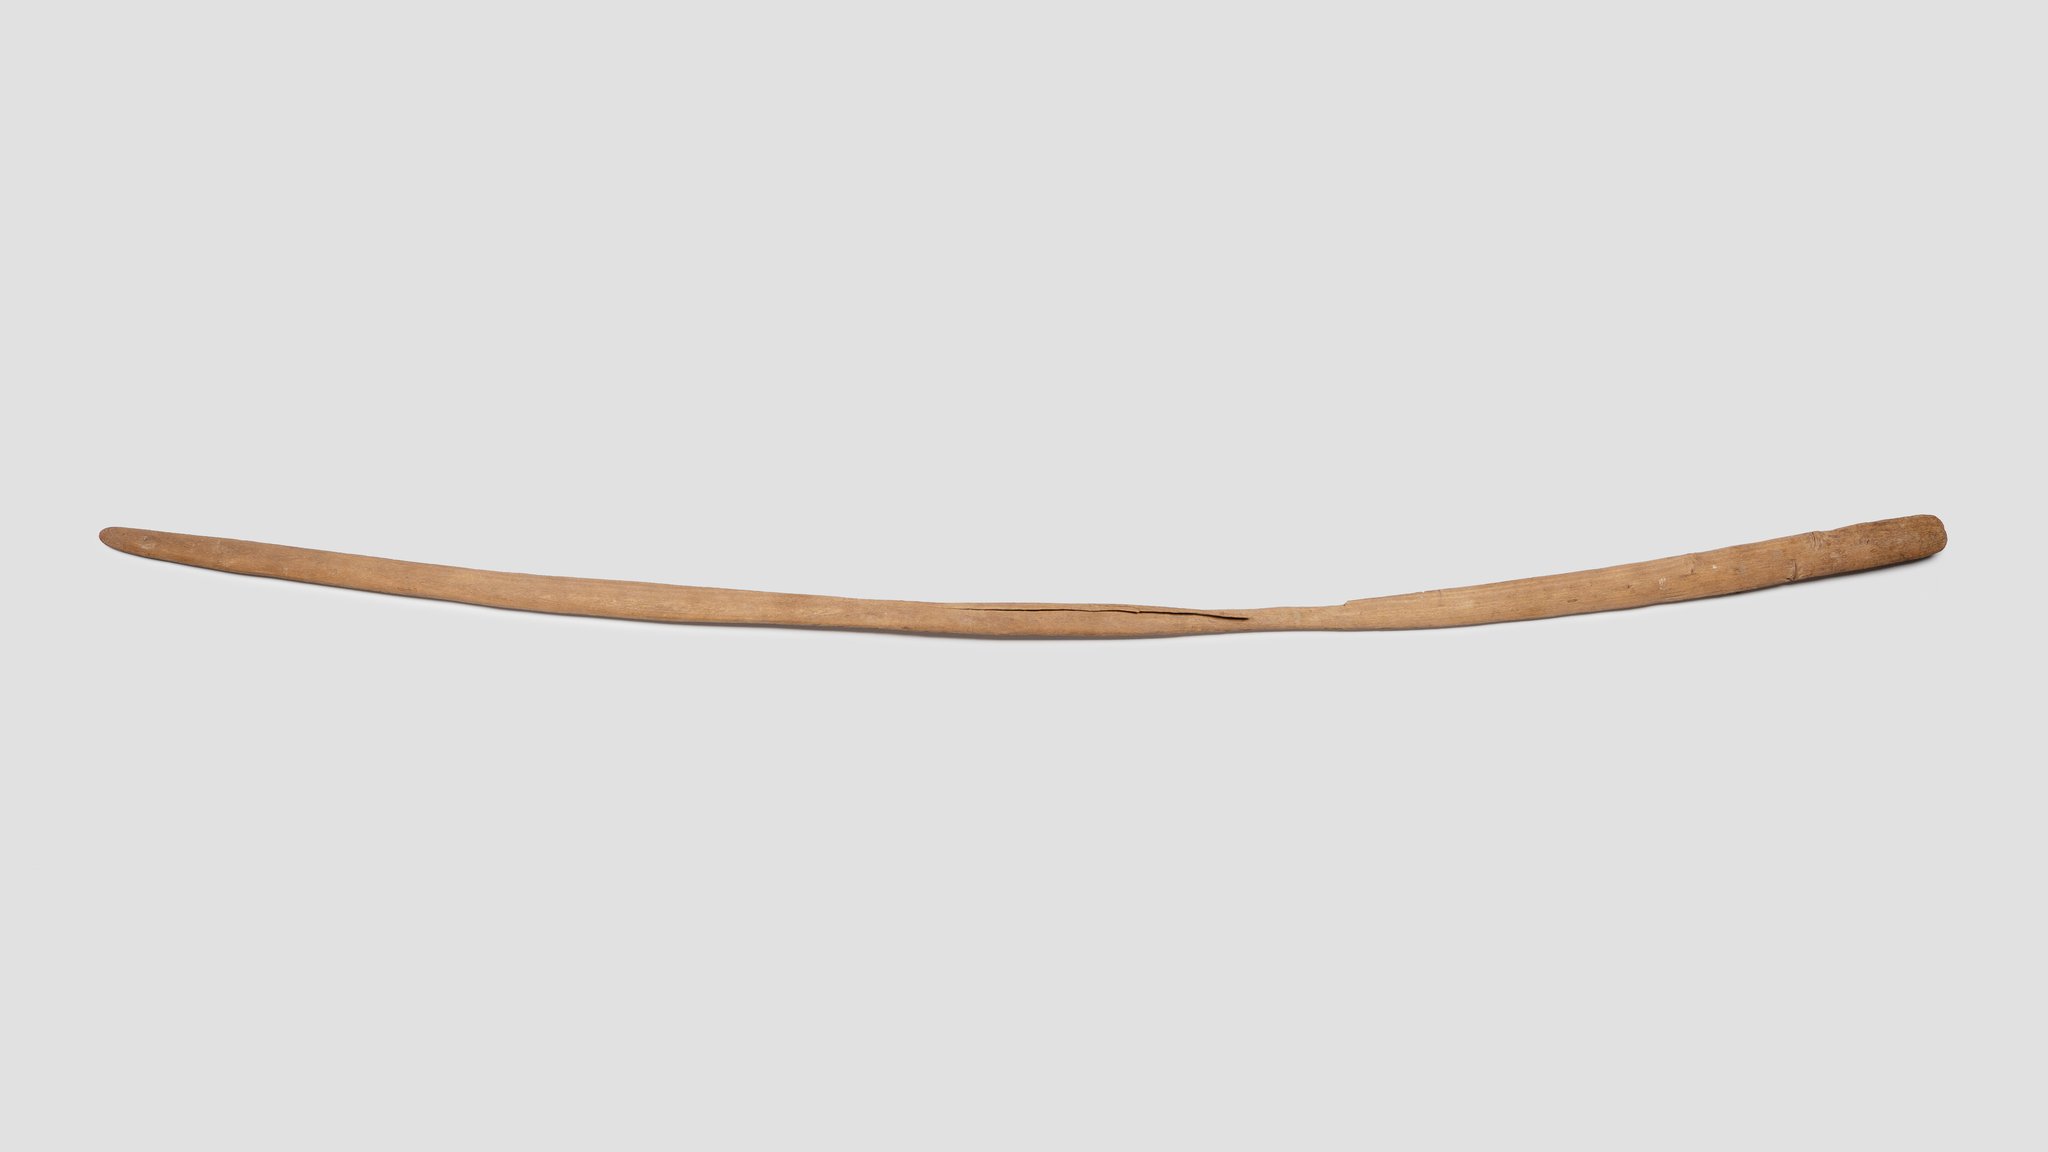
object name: weaving tool, loom beater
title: Beater-In for a Loom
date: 1991-1450 BCE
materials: wood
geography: egypt